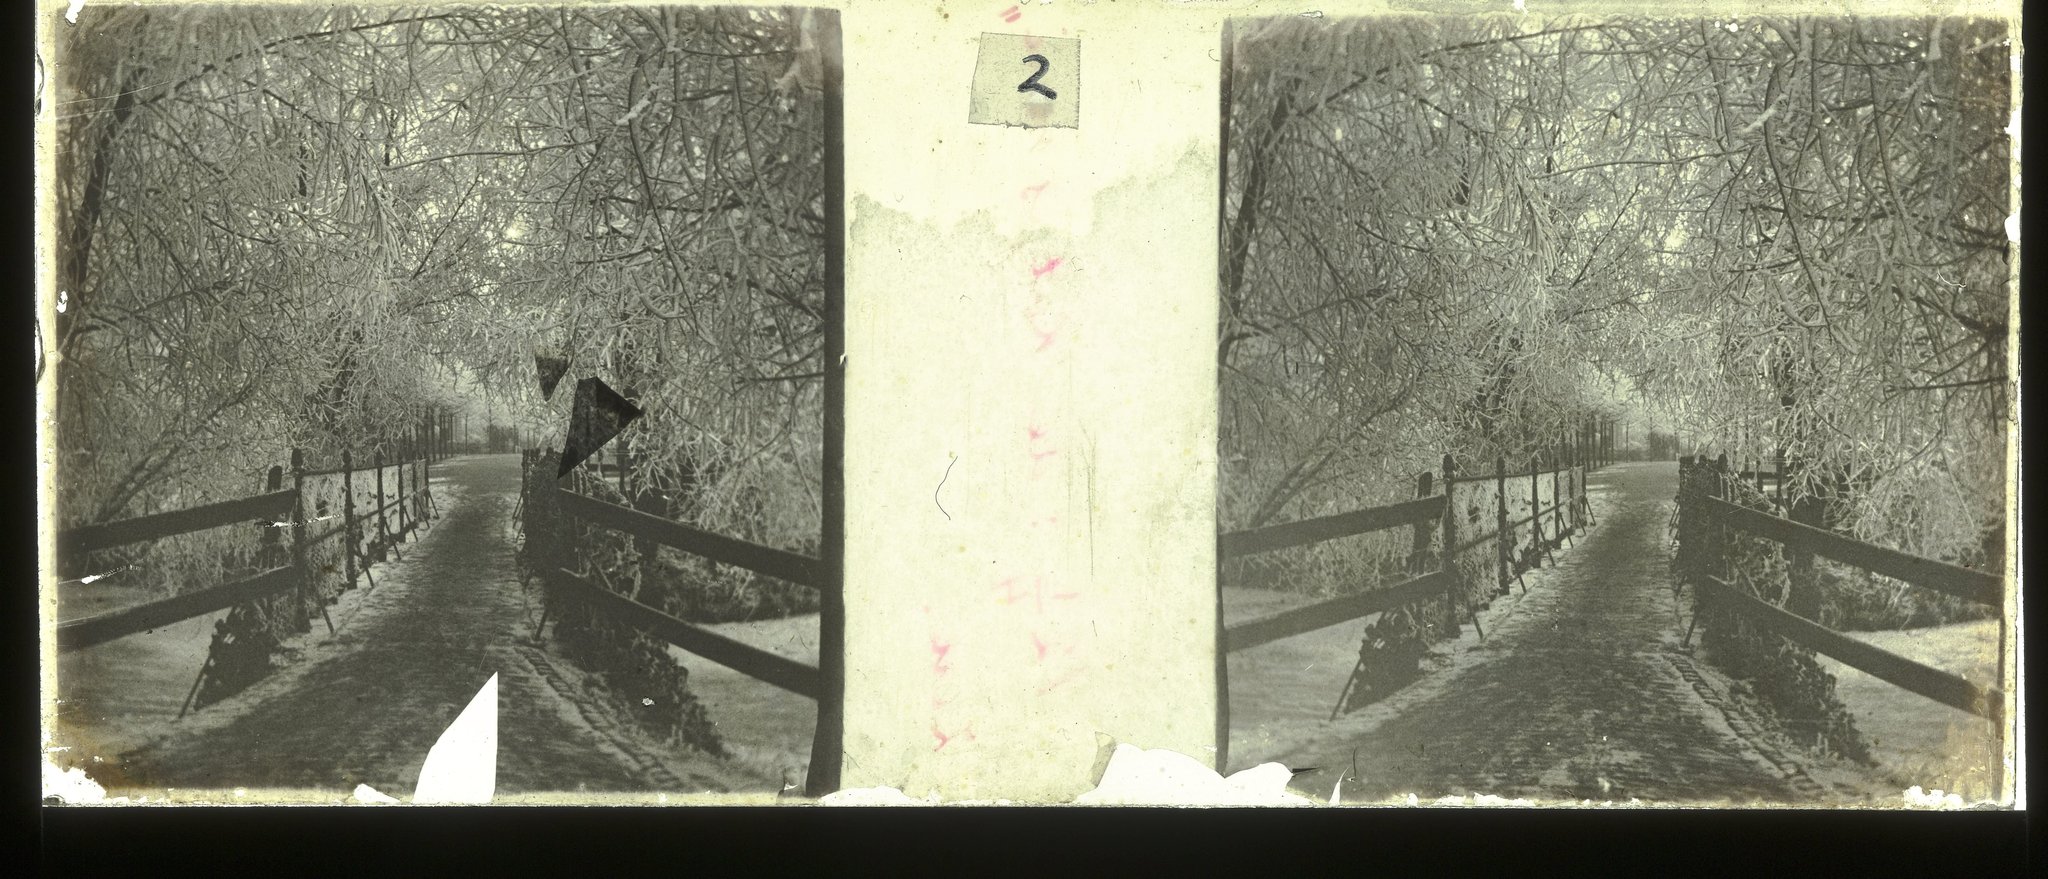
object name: stereograph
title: Landschap in Nederland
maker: theodoor brouwers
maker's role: amateurfotograaf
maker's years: 1874-1932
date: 1913-1930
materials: glass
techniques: photography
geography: netherlands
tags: amsterdam, theodoor brouwers, netherlands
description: In de periode 1911-1932 woonde op plantage Accaribo in Suriname de familie Brouwers van wie de foto's afkomstig zijn. Rond 1910 vond Theodoor Brouwers werk op plantage Accaribo. In 1929 werd hij eigenaar van de plantage. Op Accaribo werden in zijn tijd bananen geproduceerd en wat koffie.